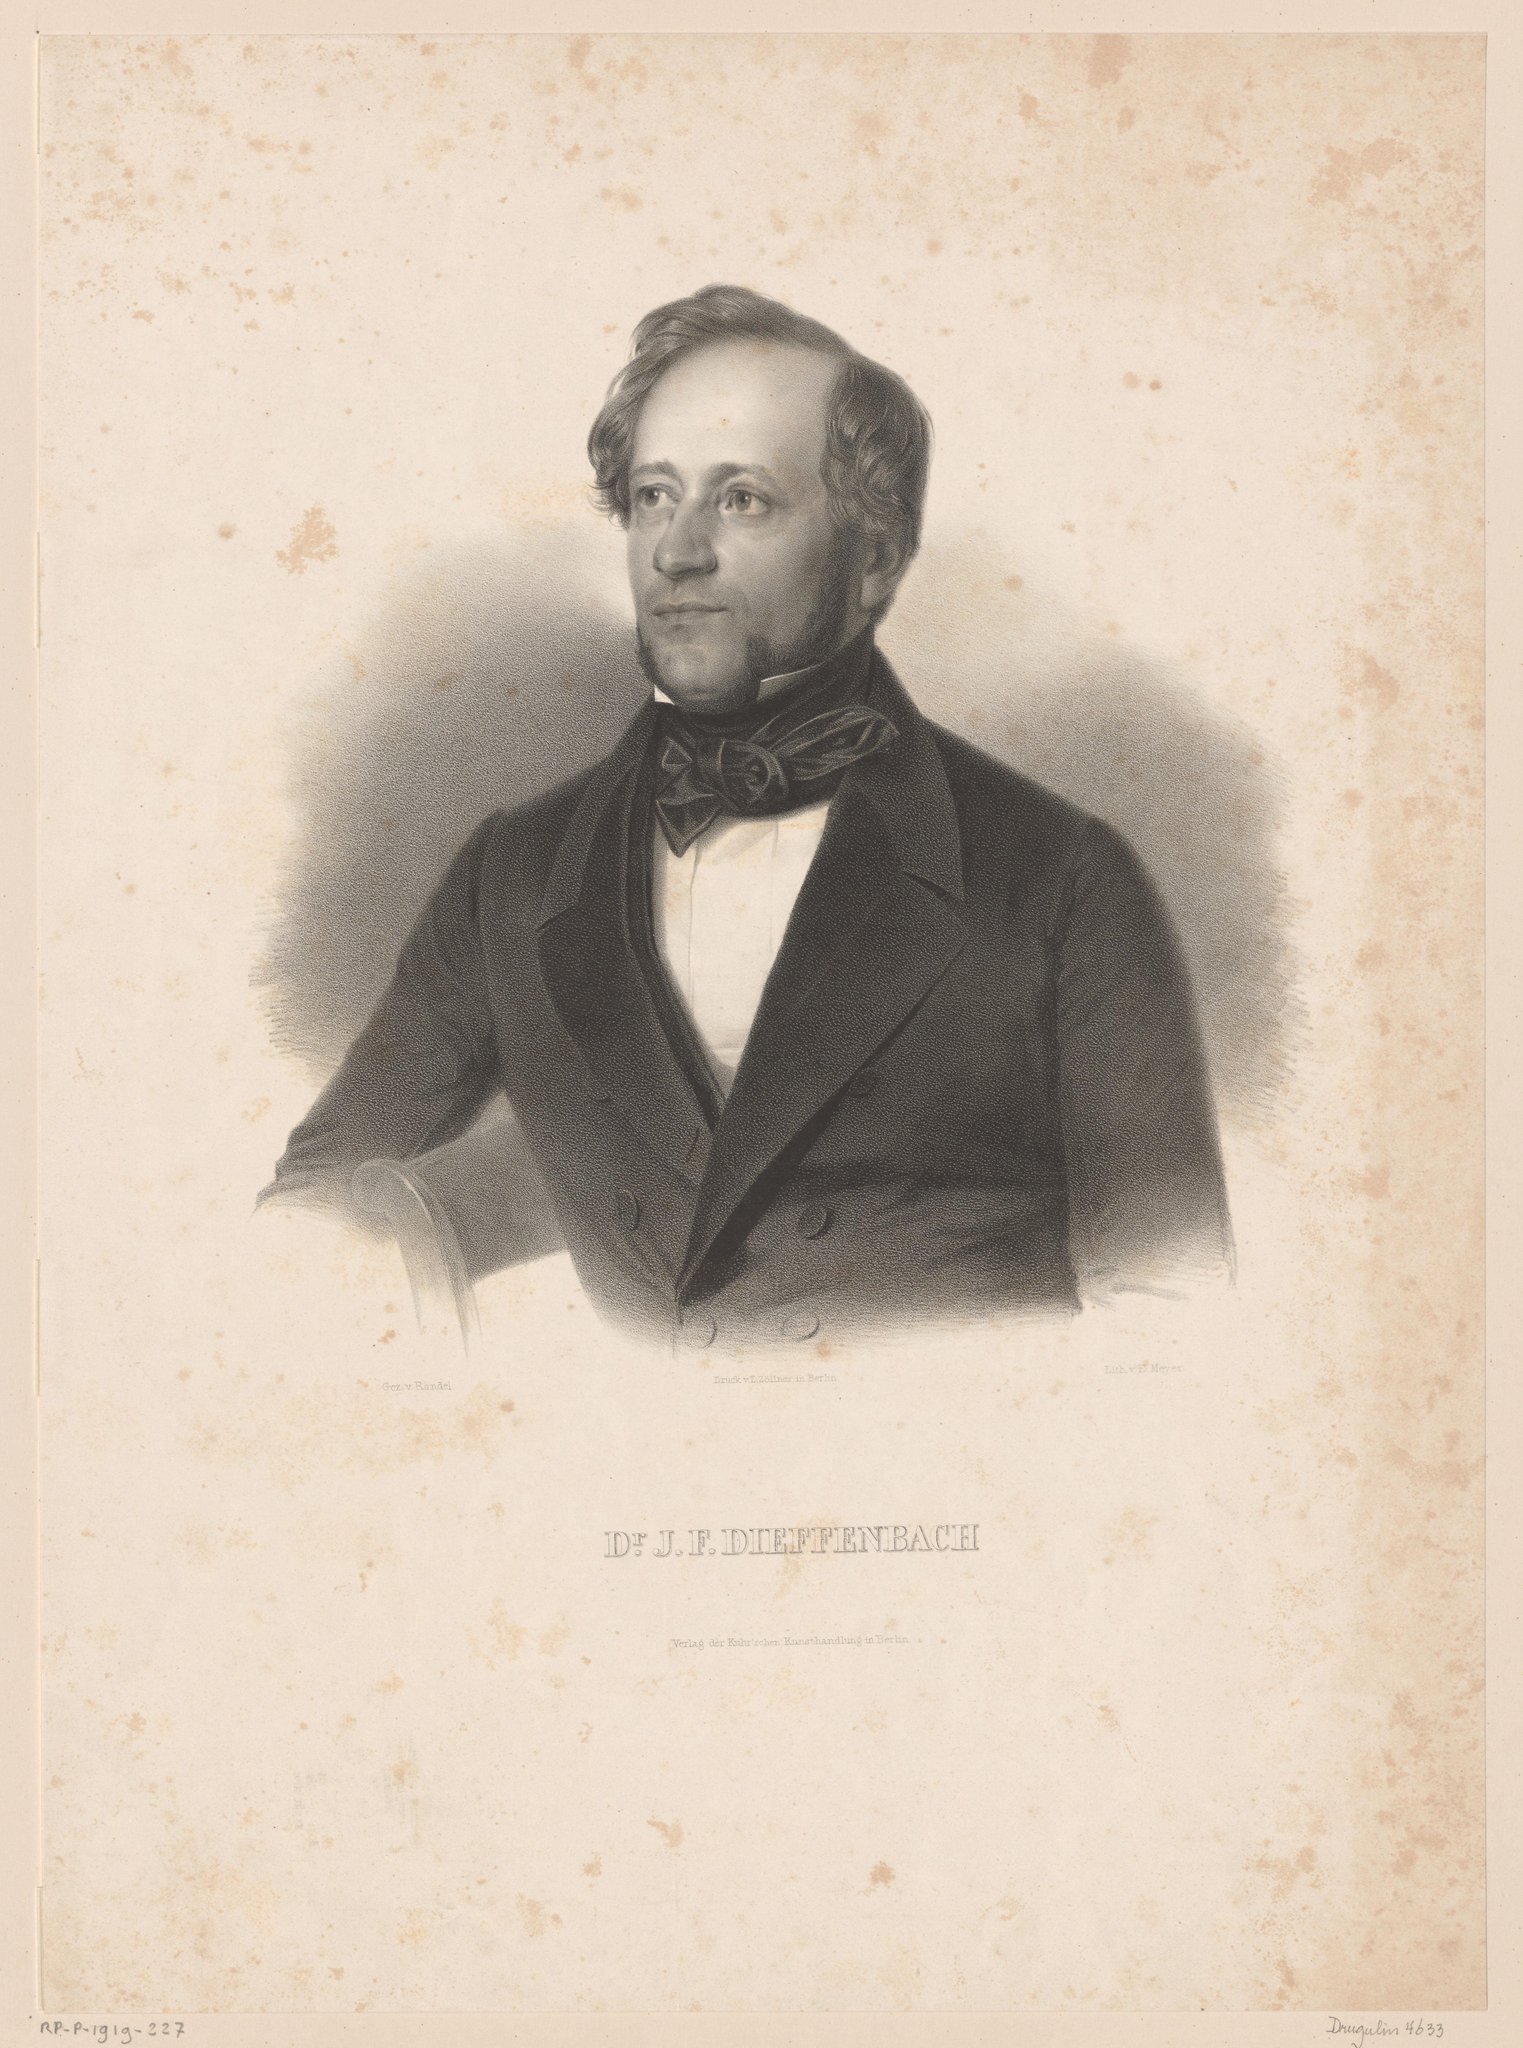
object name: print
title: Portret van Johann Friedrich Dieffenbach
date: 1820-1840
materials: paper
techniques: lithograph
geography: berlin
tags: berlin, historical persons, barber; surgeon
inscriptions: collector's mark: Lugt 2228